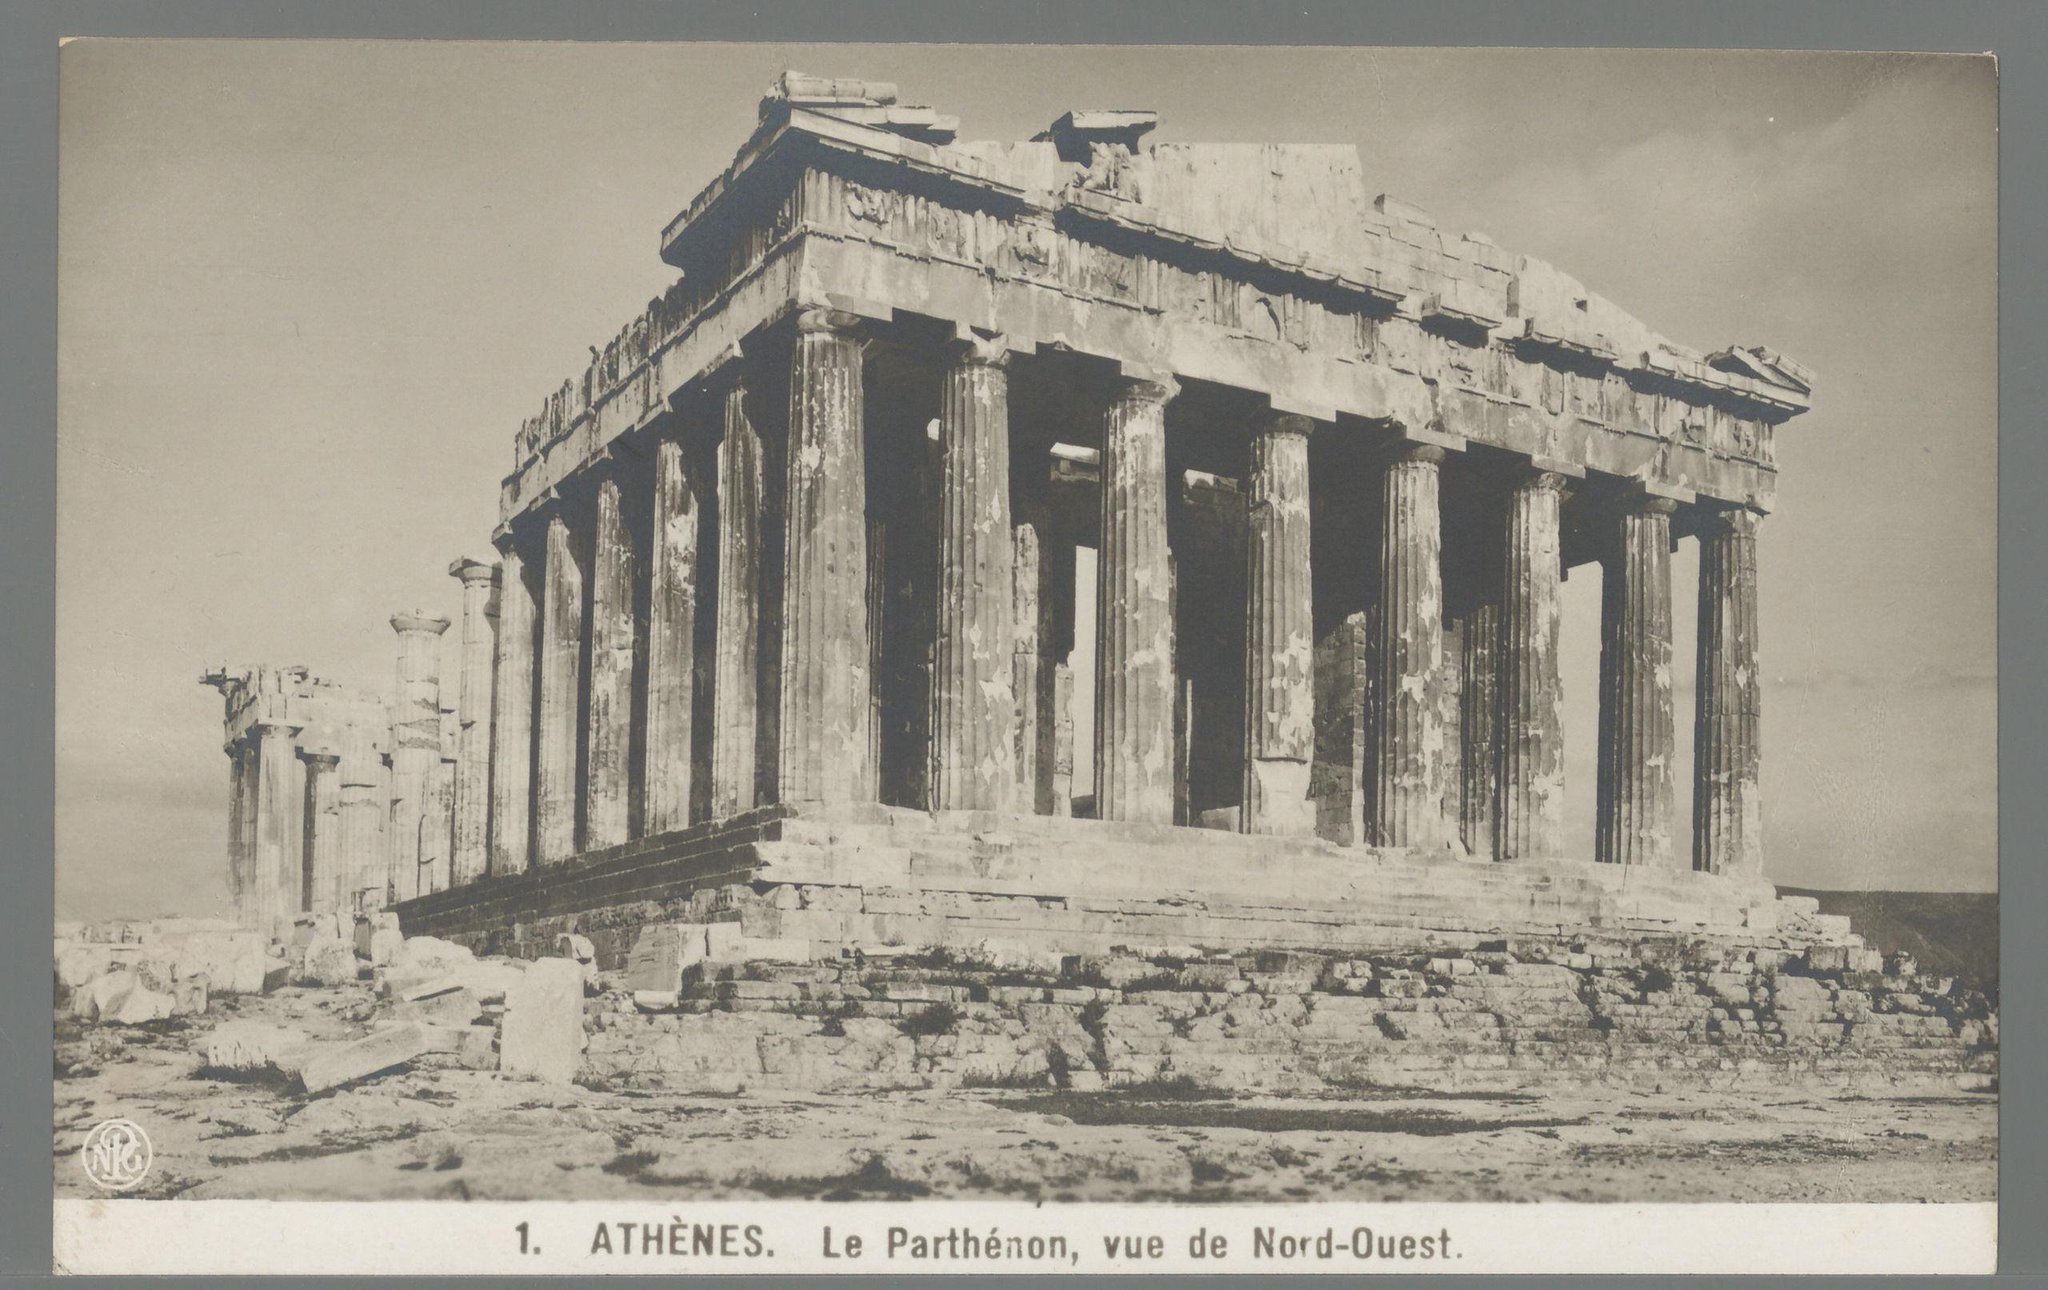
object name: photograph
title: Athènes. Le Parthénon, vue de Nord-Ouest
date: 1906-1930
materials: paper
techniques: gelatin silver print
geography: steglitz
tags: temple, shrine ~ greek religion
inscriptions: monogram: ‘P.R.A.’, monogram: ‘NPC’